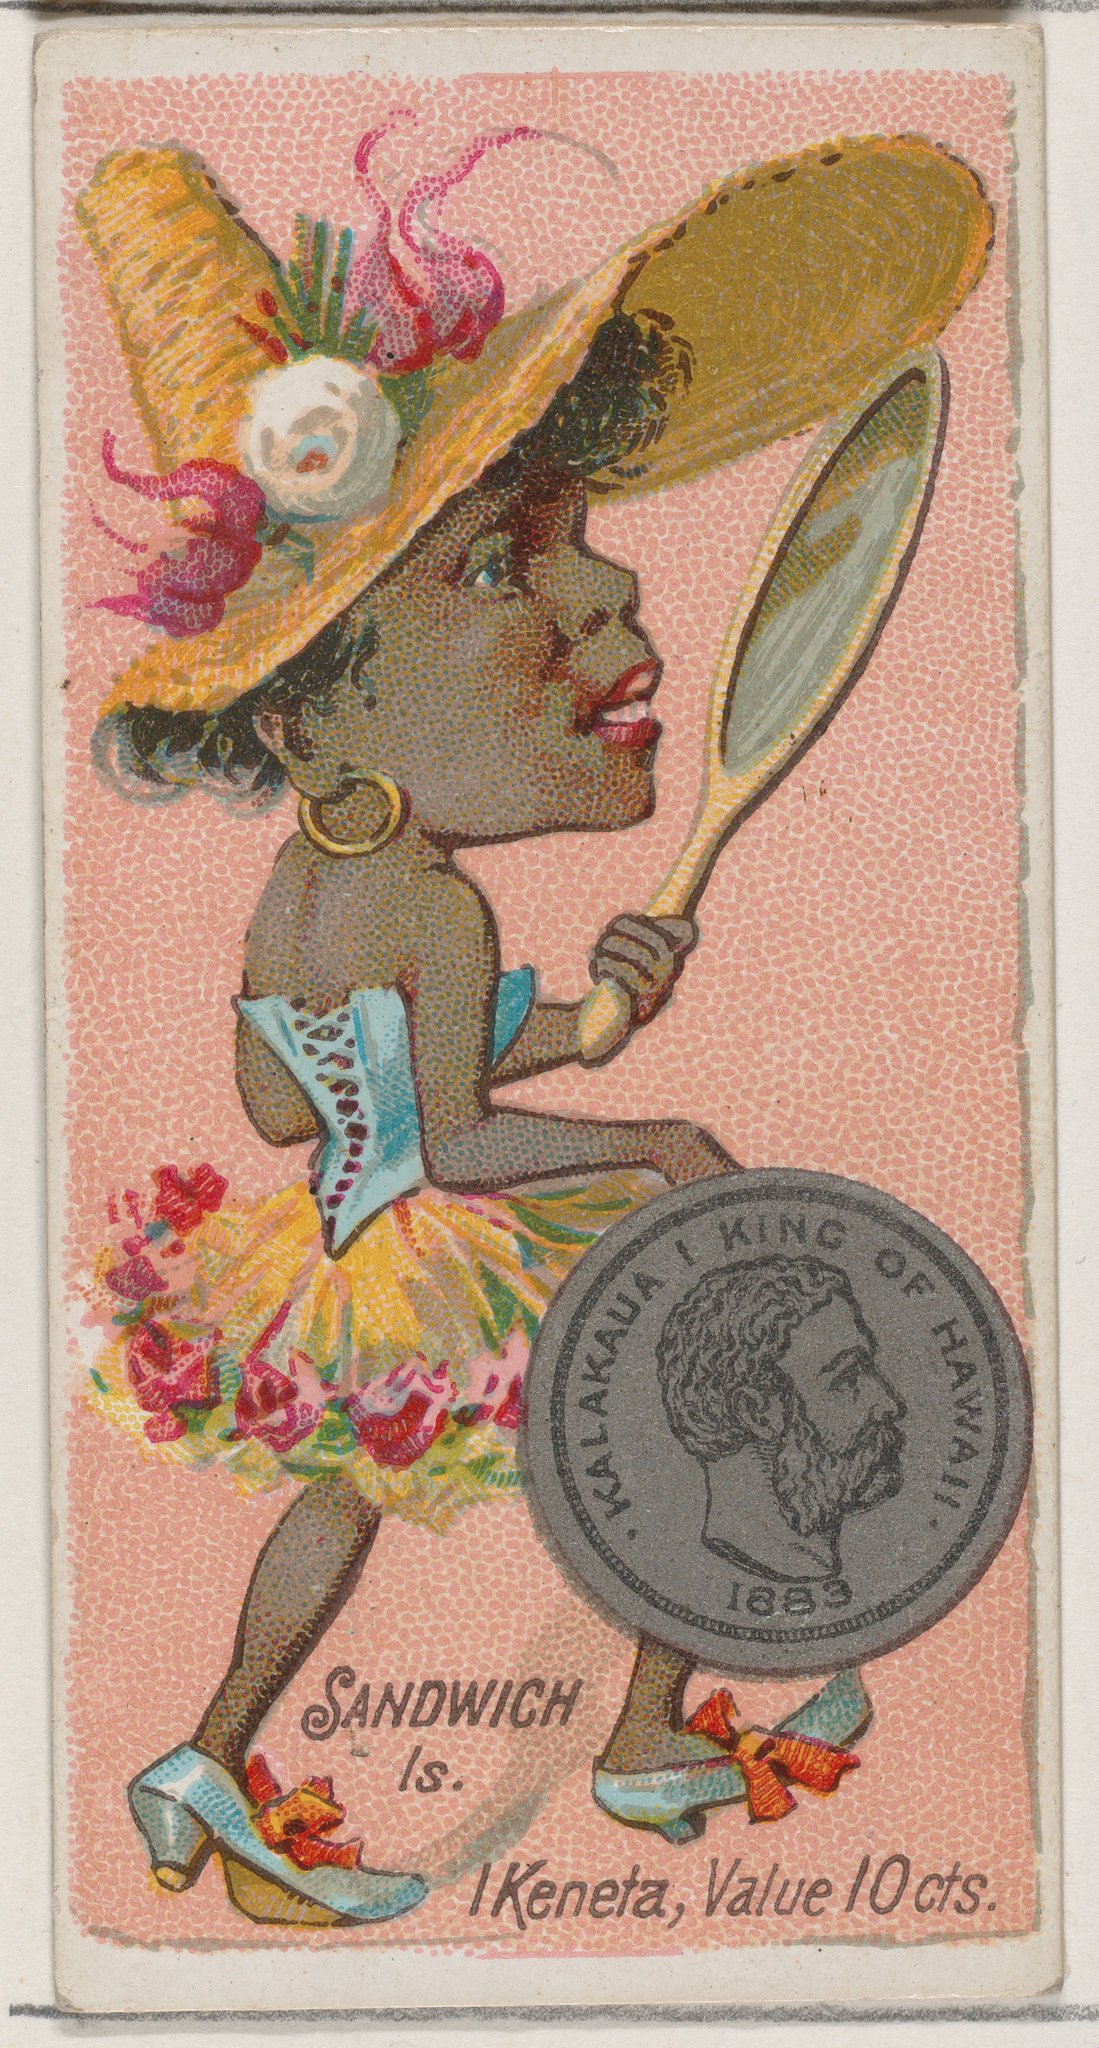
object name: print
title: Caricatured figure from the Sandwich Islands, 1 Keneta, from the series Coins of All Nations (N72, variation 2) for Duke brand cigarettes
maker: w. duke, sons & co.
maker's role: publisher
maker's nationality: american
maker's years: 1870-1920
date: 1889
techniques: color lithograph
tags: women,coins